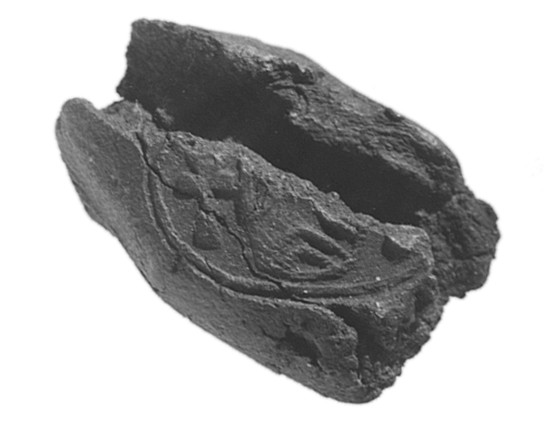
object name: sealing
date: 2030-1640 BCE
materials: clay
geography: egypt